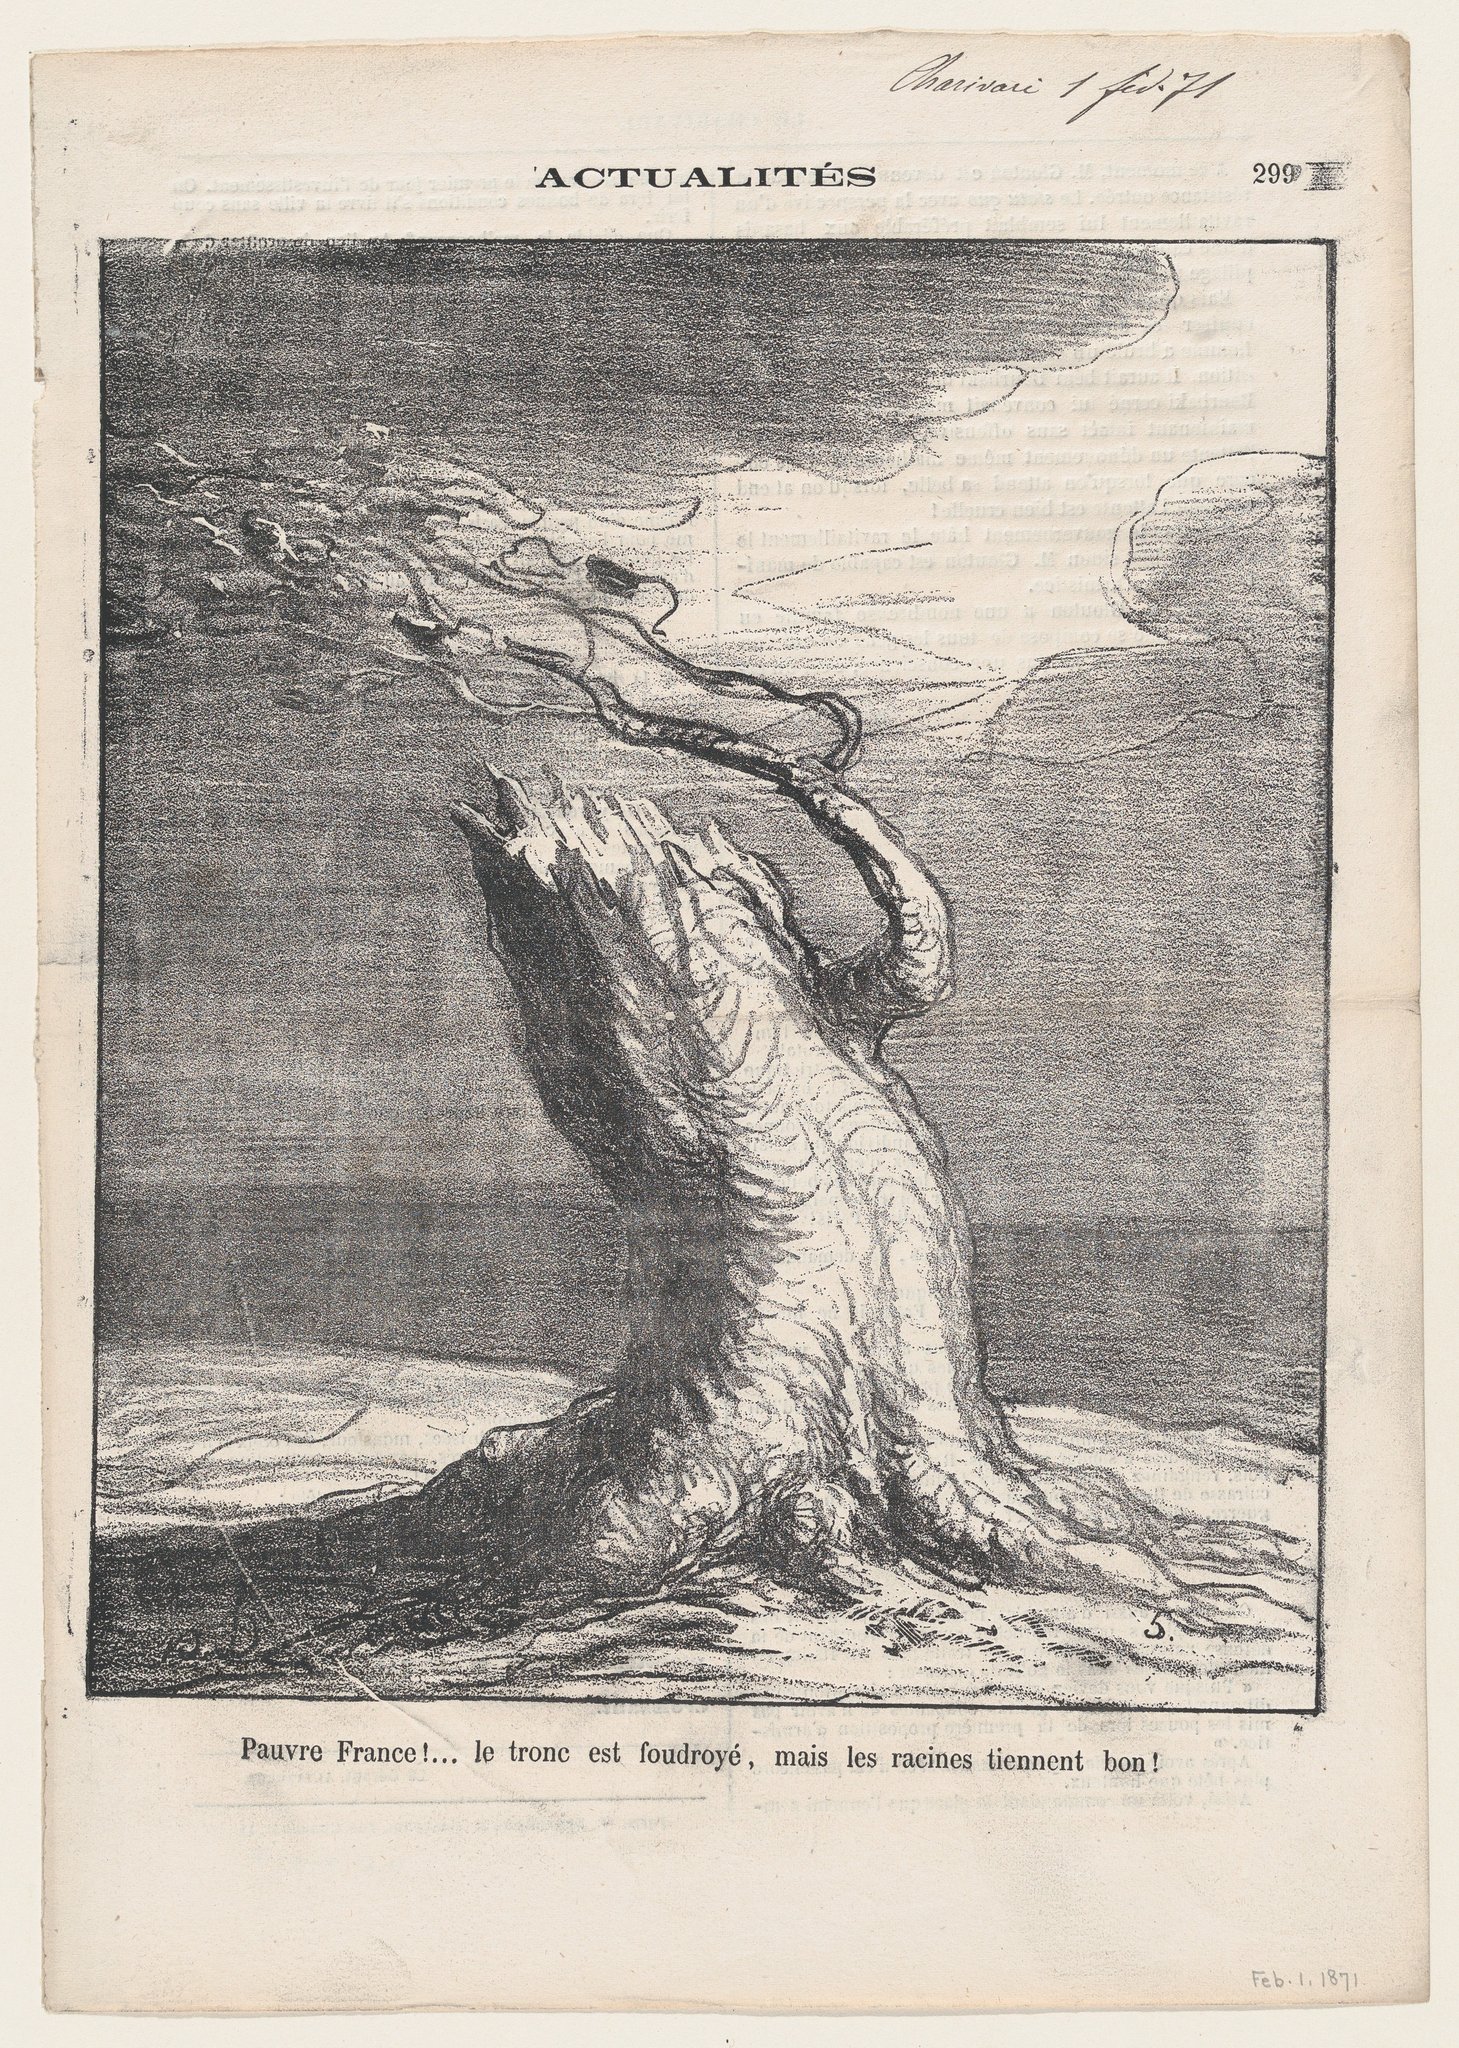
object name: print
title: Poor France... the trunk was struck by lightning, but the roots hold fast, from 'News of the day,' published in Le Charivari, February 1, 1871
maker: honoré daumier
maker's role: artist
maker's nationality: french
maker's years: 1808-1879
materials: paper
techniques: lithograph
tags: satire,trees